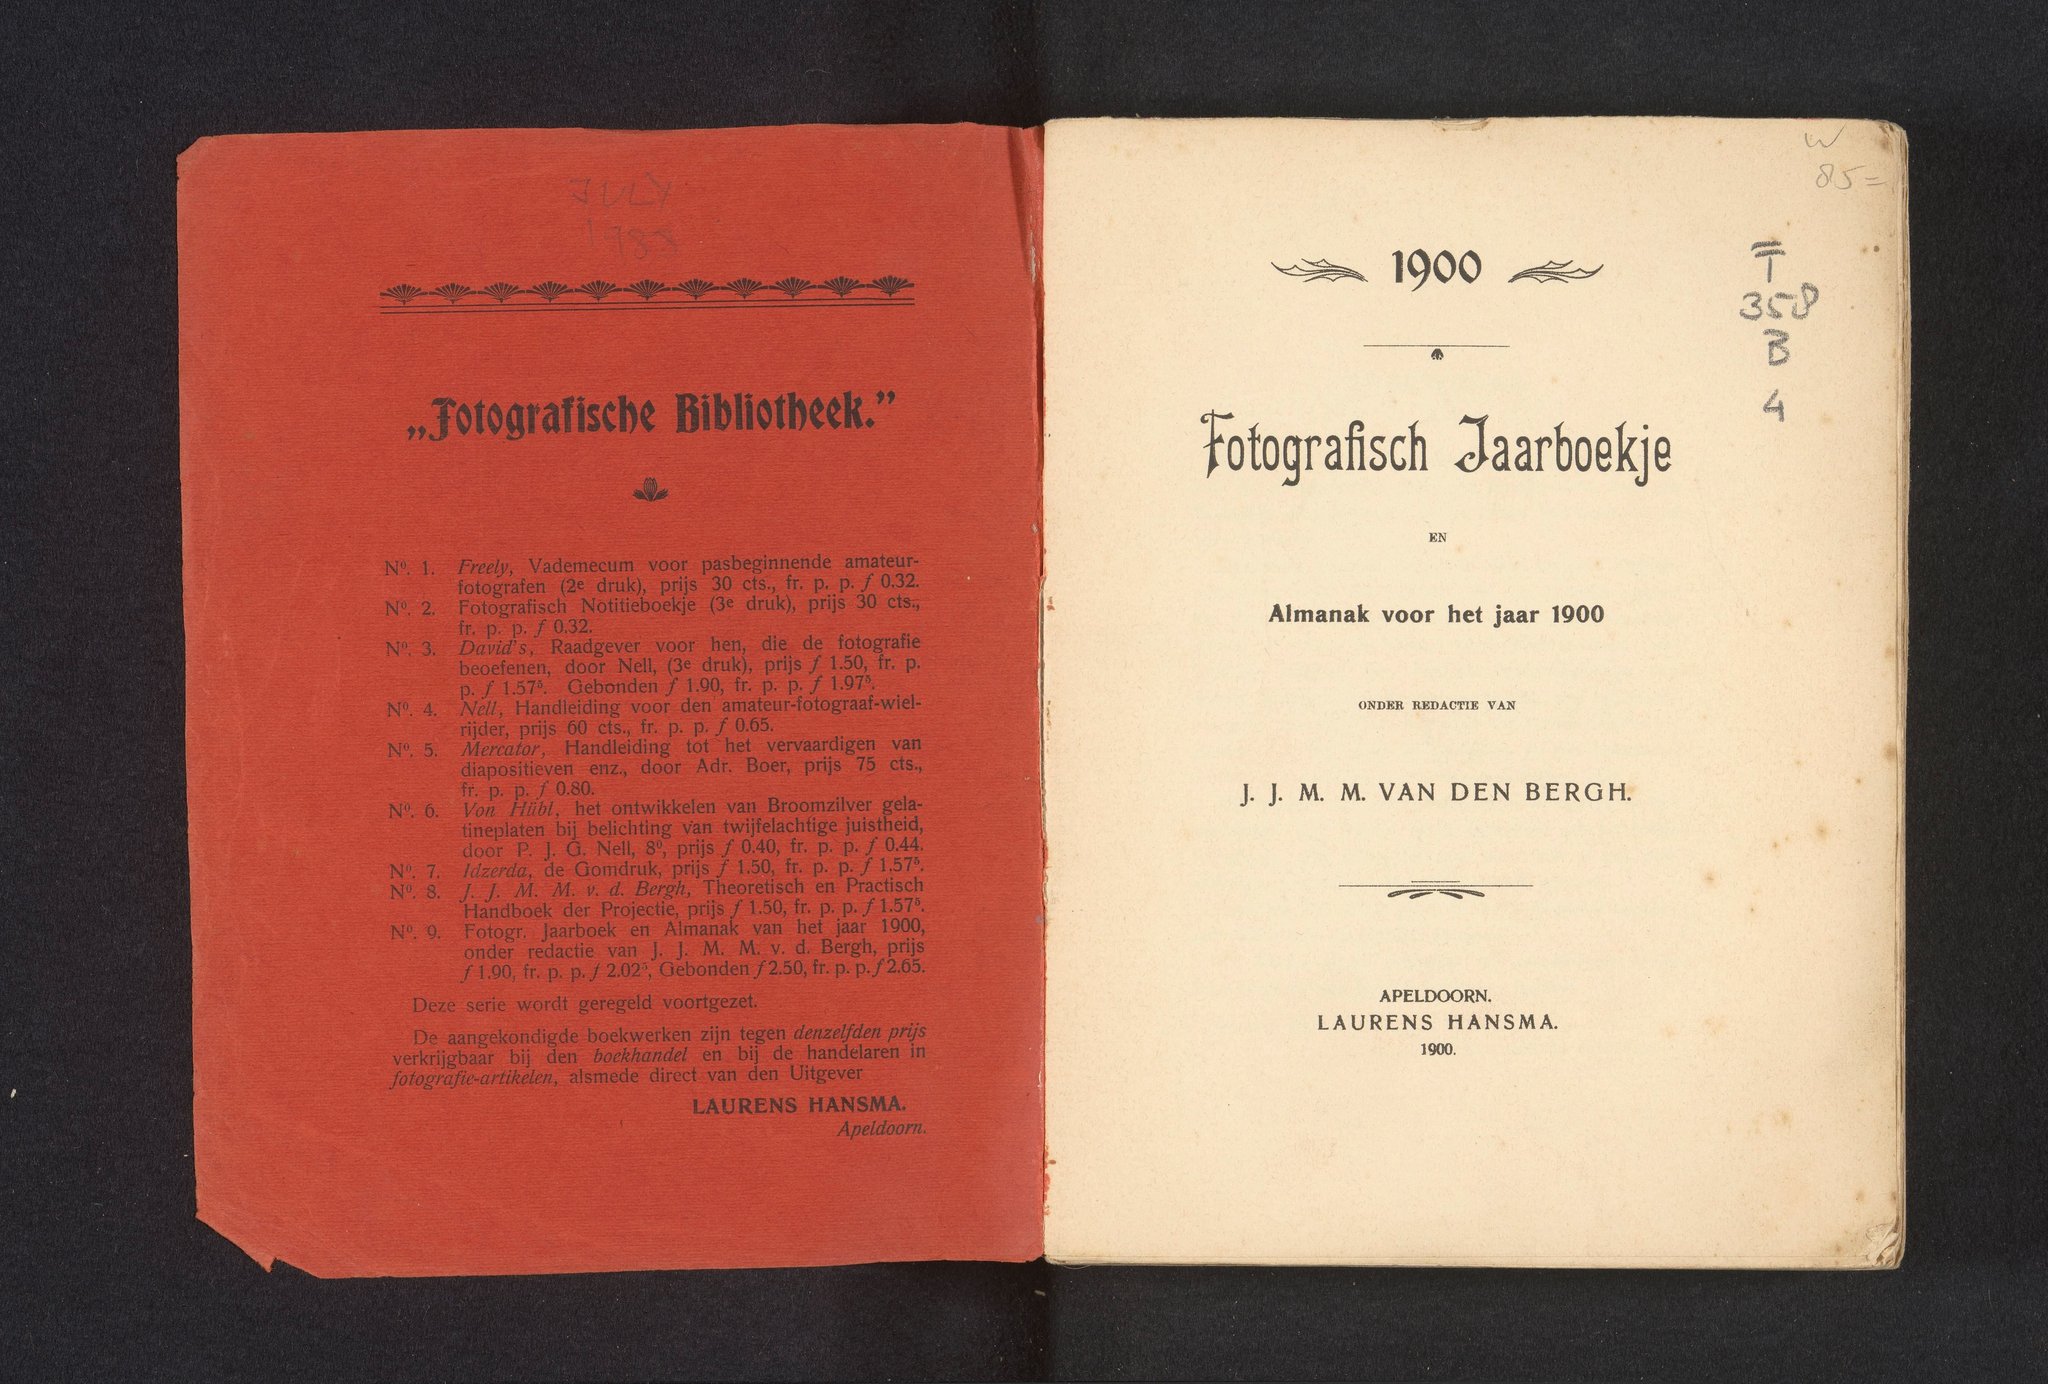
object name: book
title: Fotografisch jaarboek en almanak voor het jaar 1900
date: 1900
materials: cardboard, paper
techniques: photoaquatint, printing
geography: apeldoorn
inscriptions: annotation: ‘JULY/ 1983’, name: ‘JOH. M. VAN OLST/ ARTS’, annotation: ‘W/ 85=’